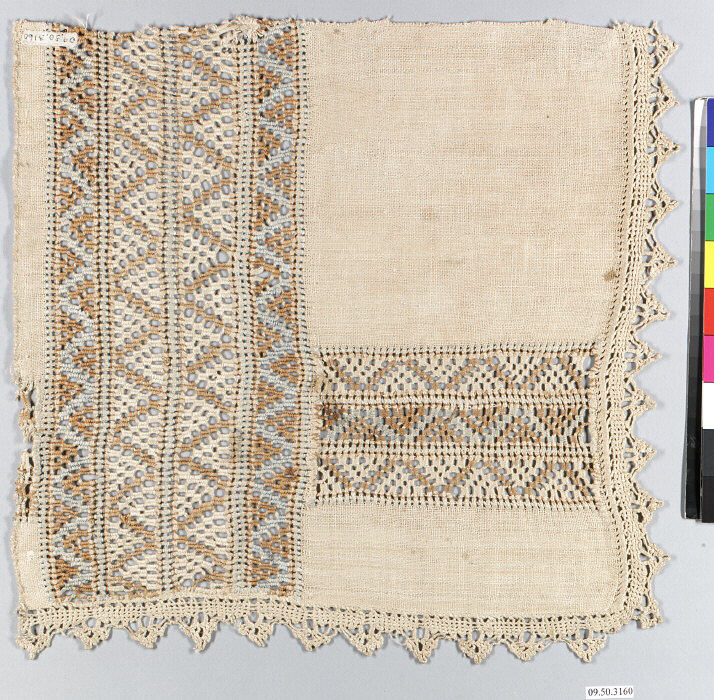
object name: fragment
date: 1701-1800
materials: silk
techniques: lace, embroidery